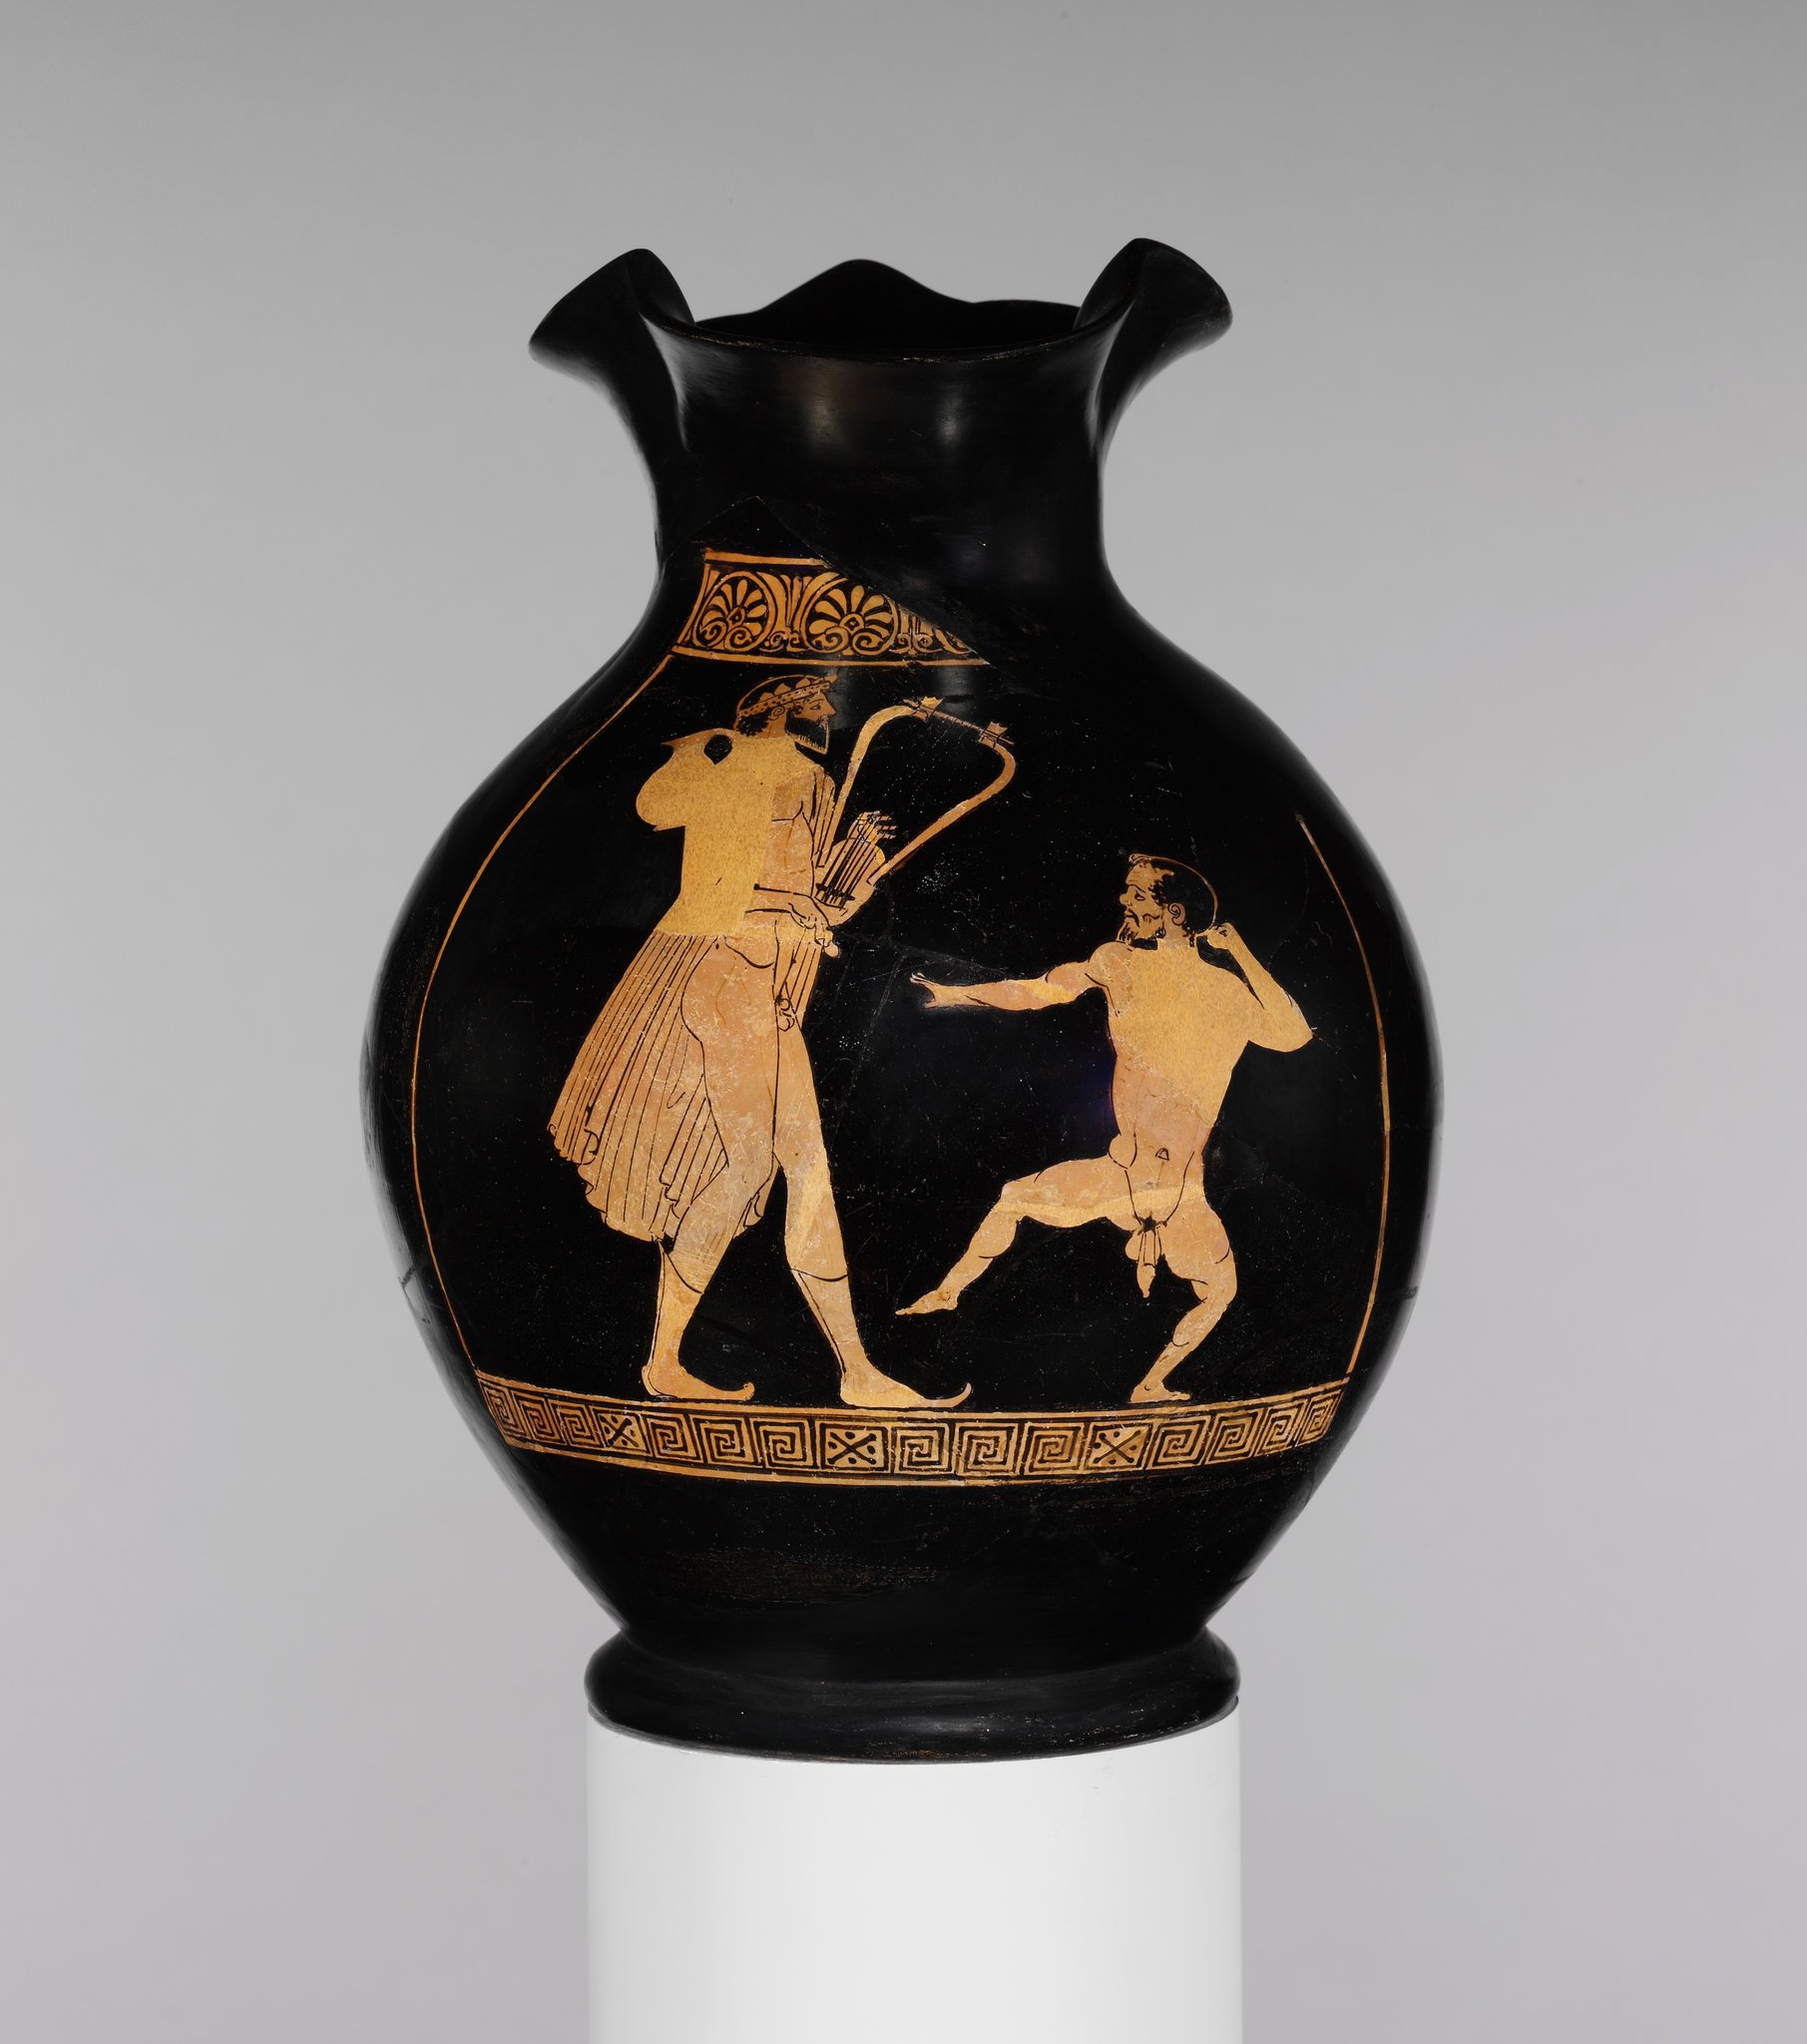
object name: oinochoe, chou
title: Terracotta oinochoe: chous (jug)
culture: greek, attic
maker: niobid painter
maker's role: artist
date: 450 BCE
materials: terracotta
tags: musical instruments,men